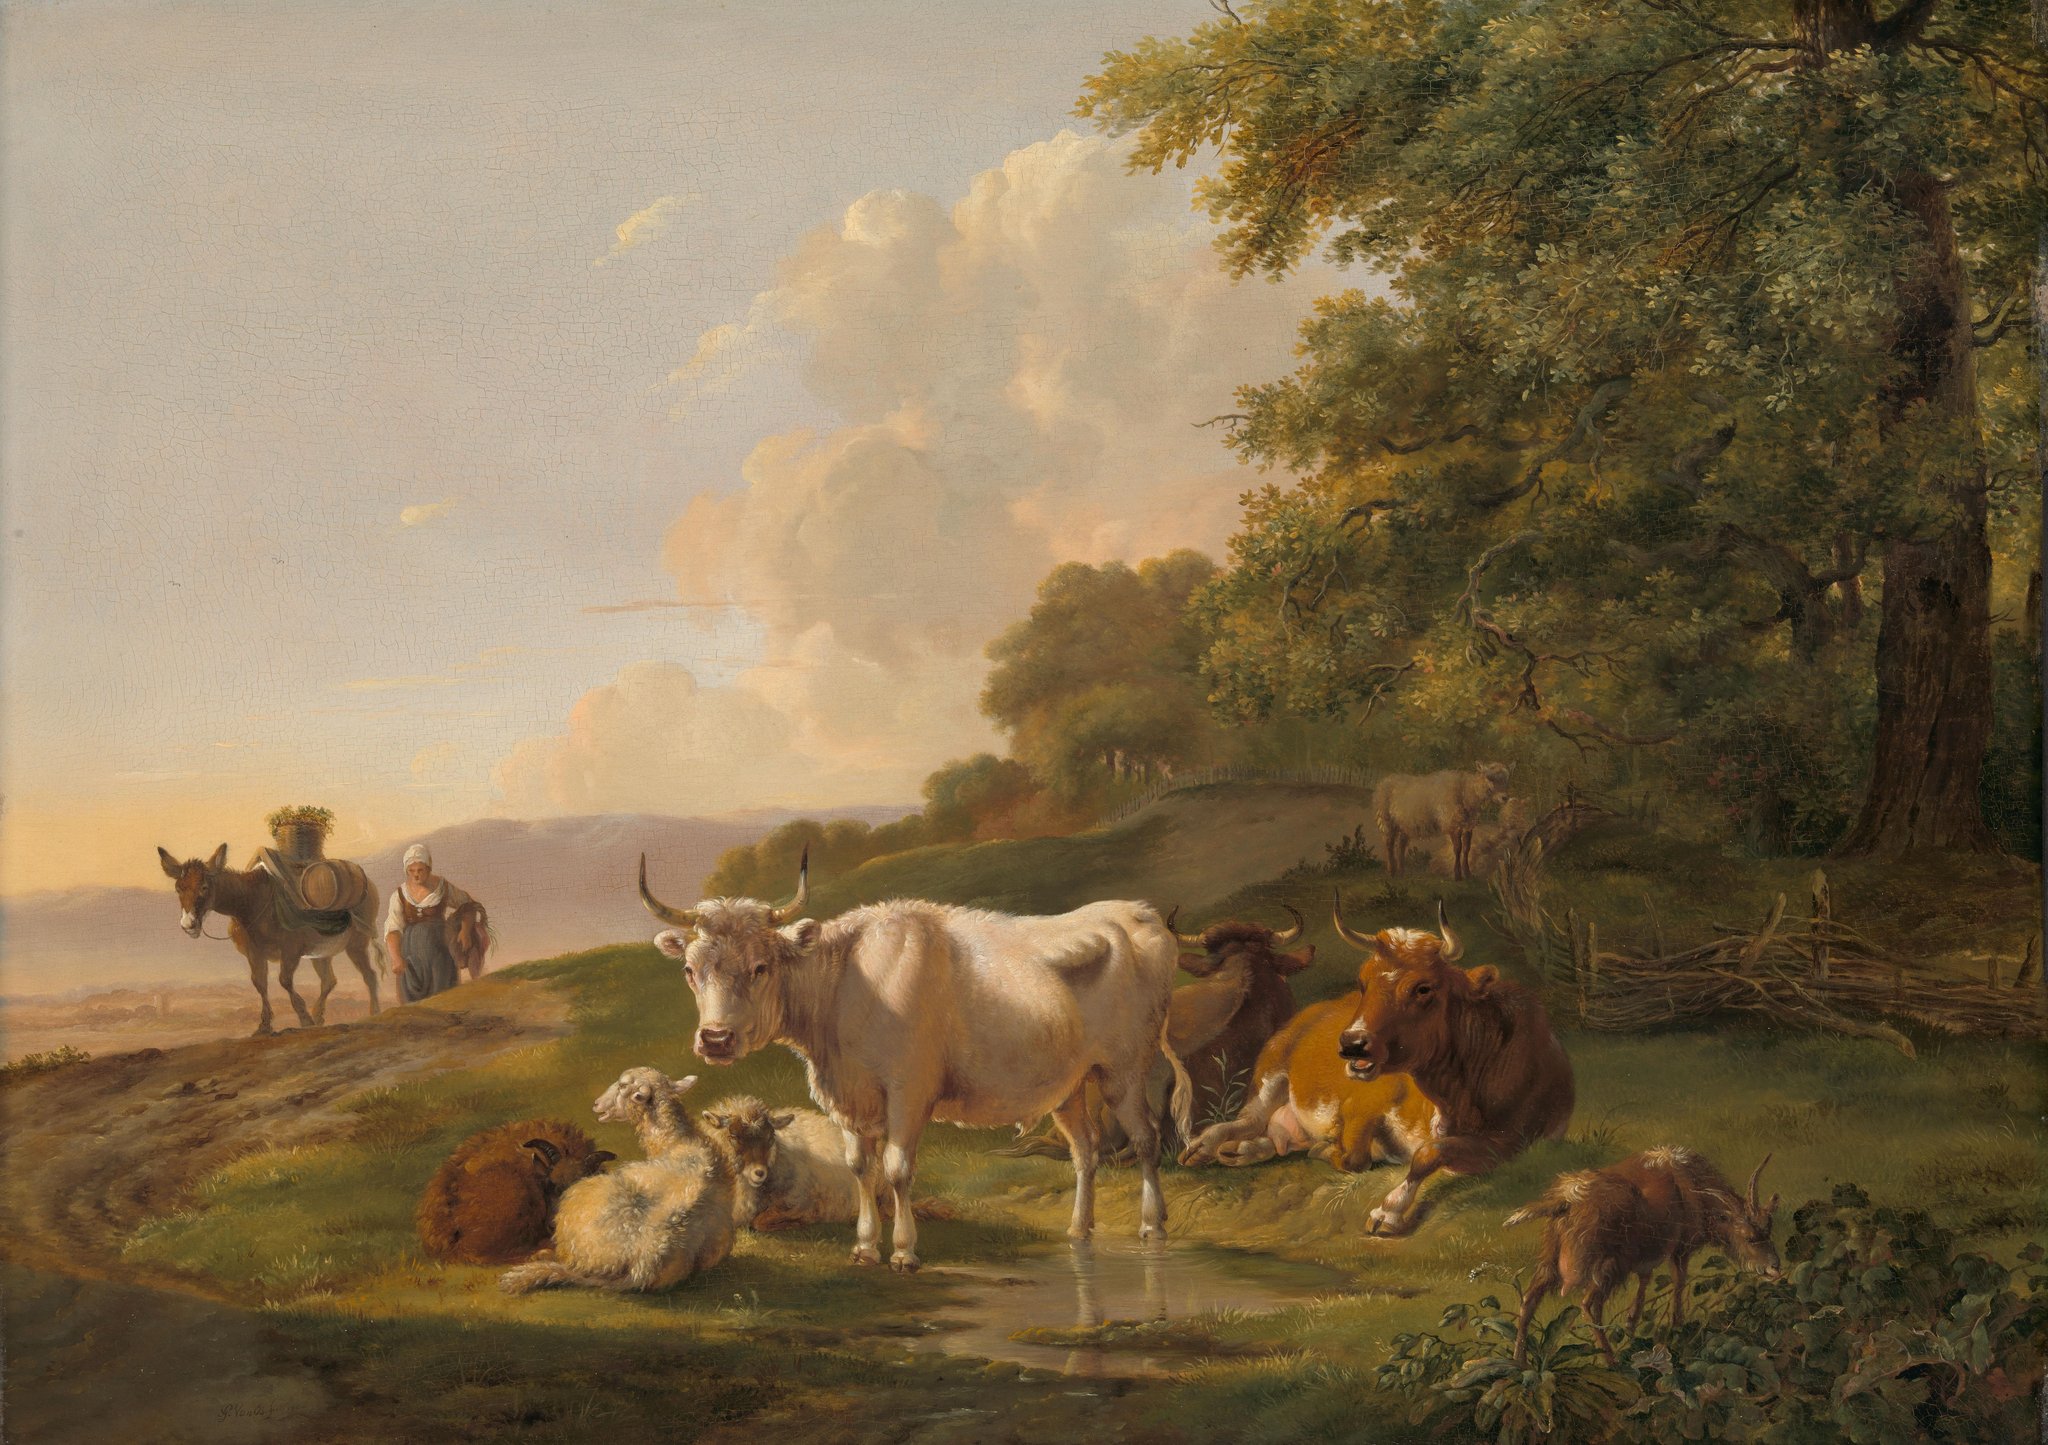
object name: painting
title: Landscape with Cattle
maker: pieter gerardus van os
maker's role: draughtsman, painter, print maker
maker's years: 1776-1839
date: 1806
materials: oil, panel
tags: sheep, bovine cattle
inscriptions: signature and date: ‘P.G. van Os 1806’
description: Landschap met vee. Bij een plas langs een weg bevinden zich enkele koeien en schapen, rechts eet een geit van de struiken. Over de weg komt een boerin met een ezel.